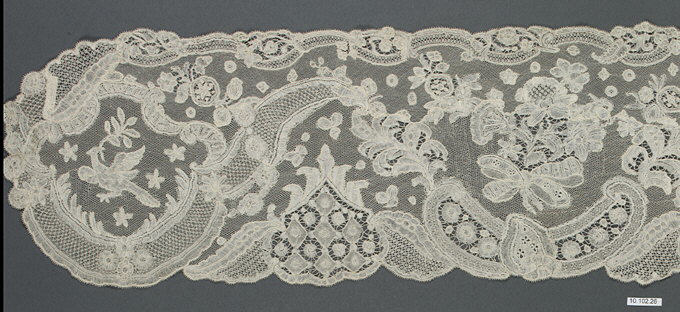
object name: barbe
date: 1701-1733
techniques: lace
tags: birds,flowers